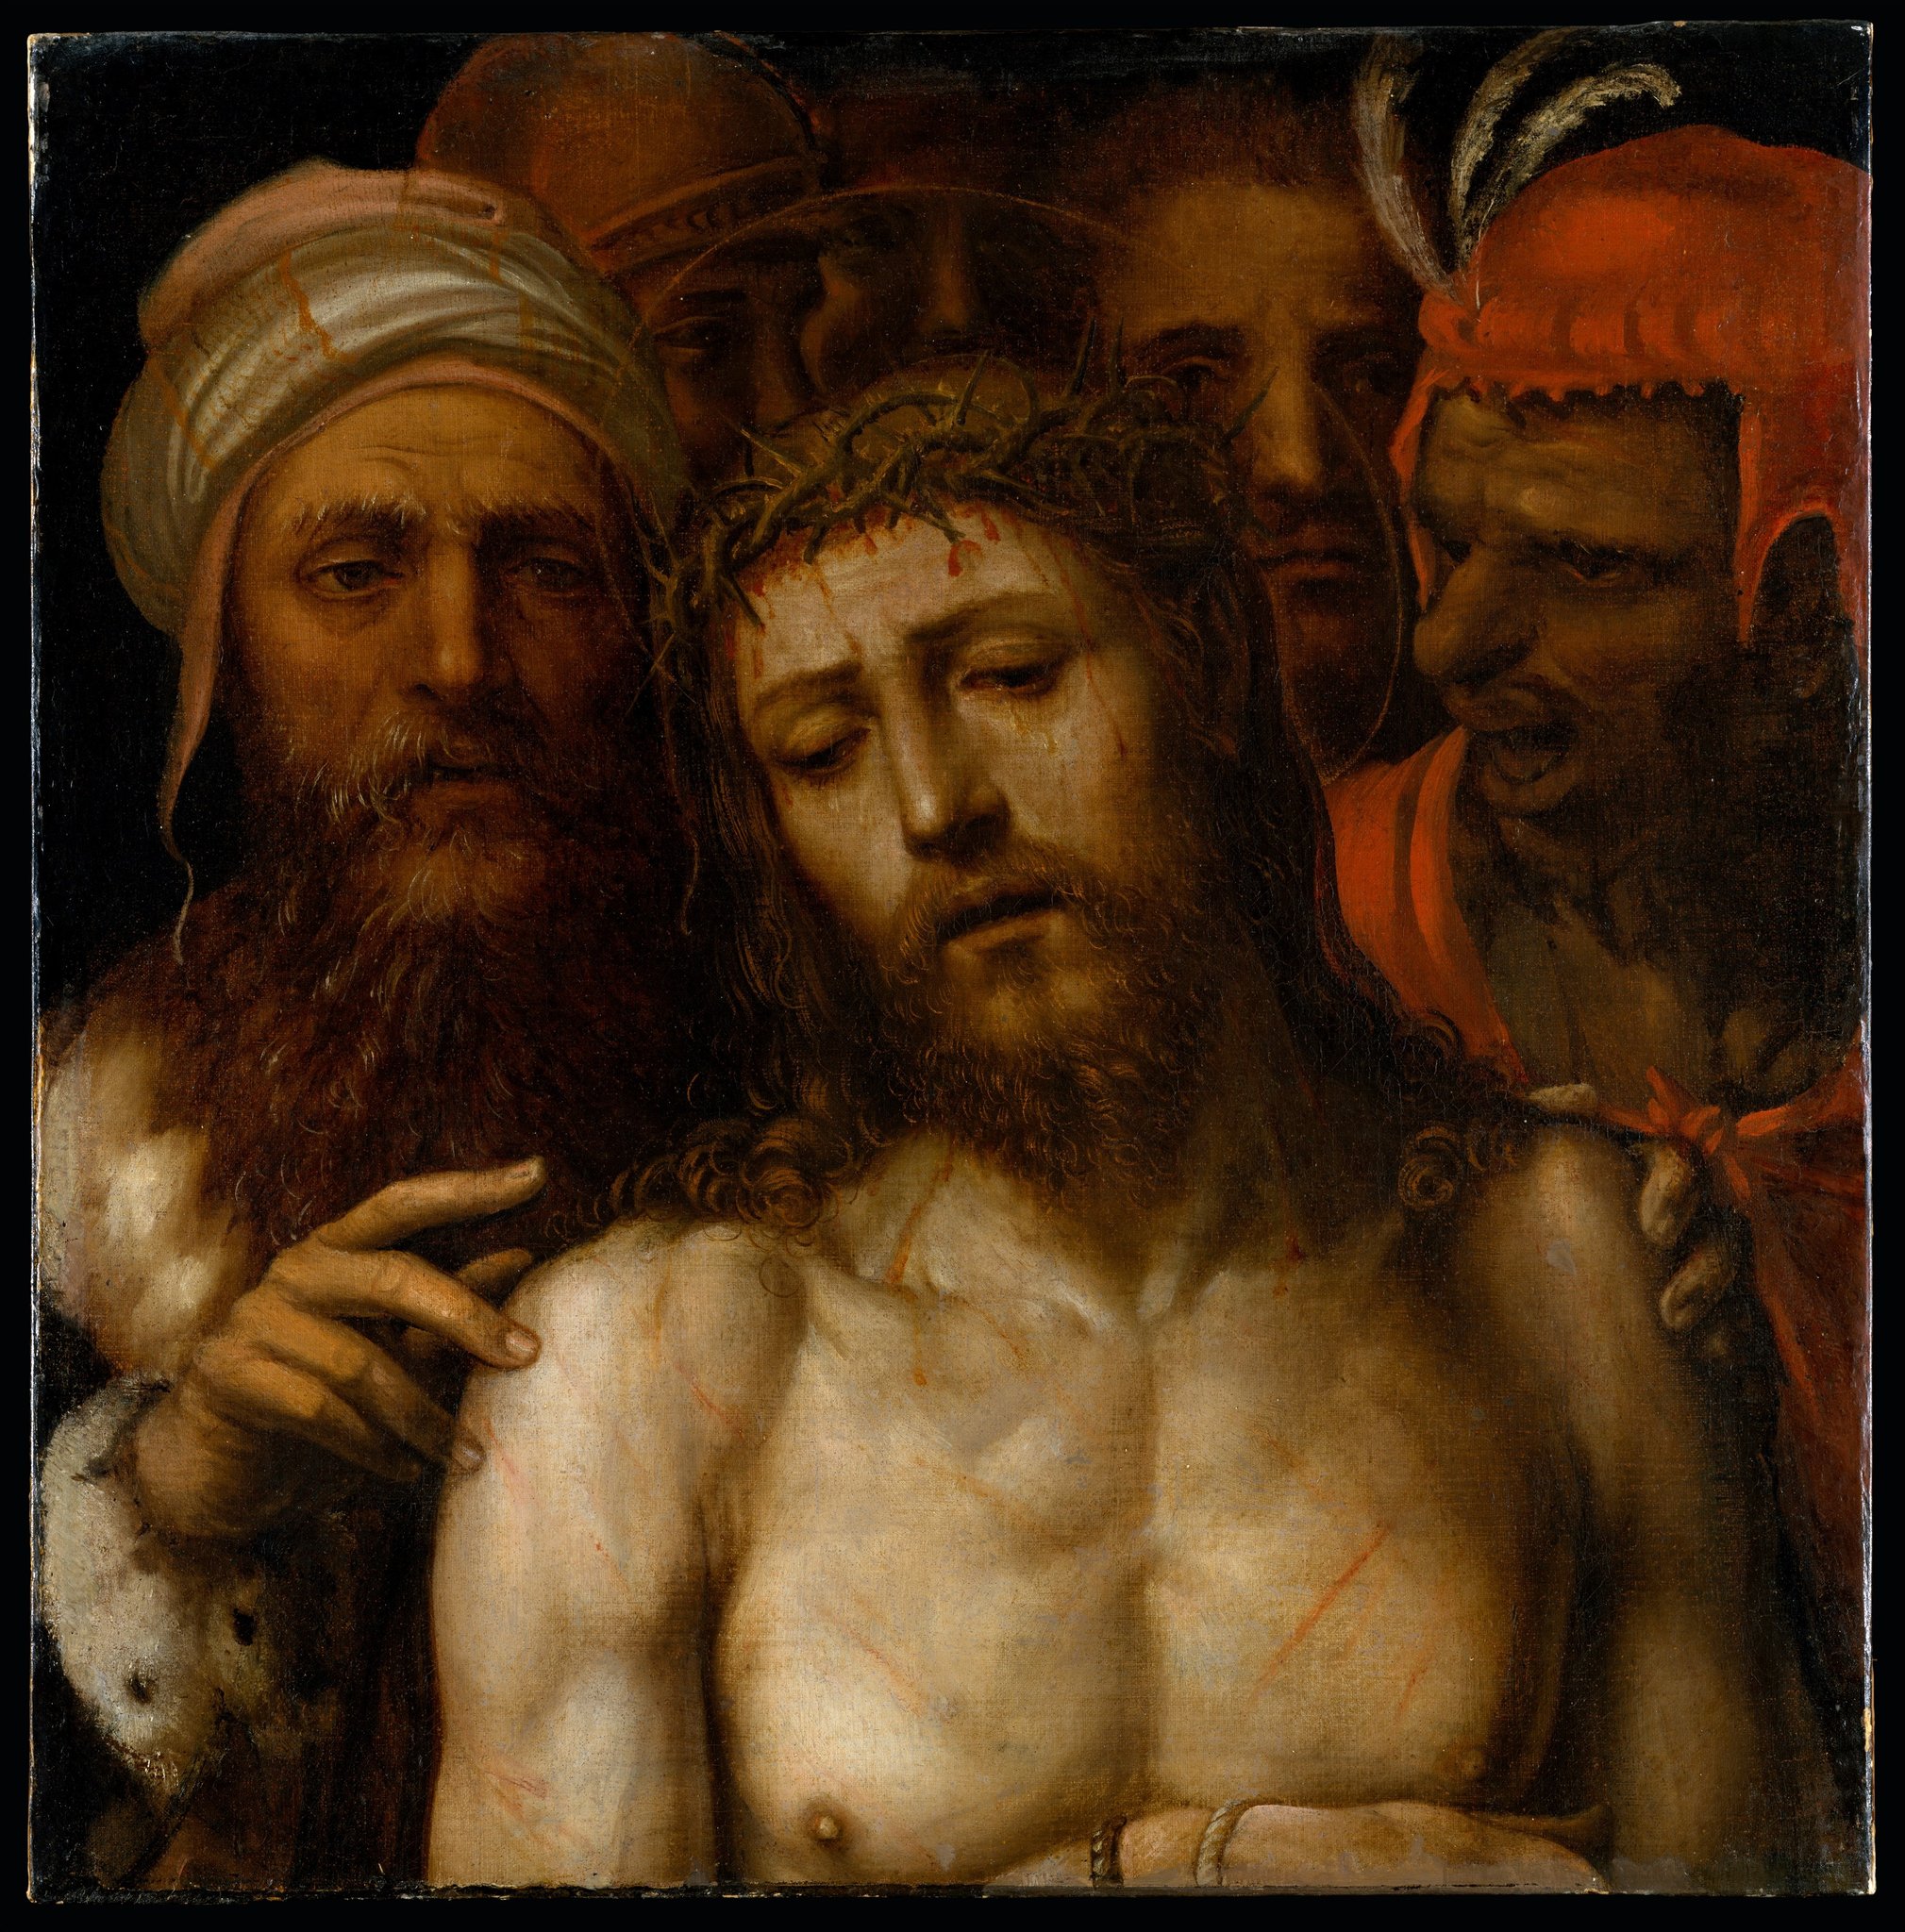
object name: painting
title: Christ Presented to the People (Ecce Homo)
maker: sodoma (giovanni antonio bazzi)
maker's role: artist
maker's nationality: italian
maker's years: 1477-1549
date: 1540-1549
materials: canvas, oil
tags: men,christ